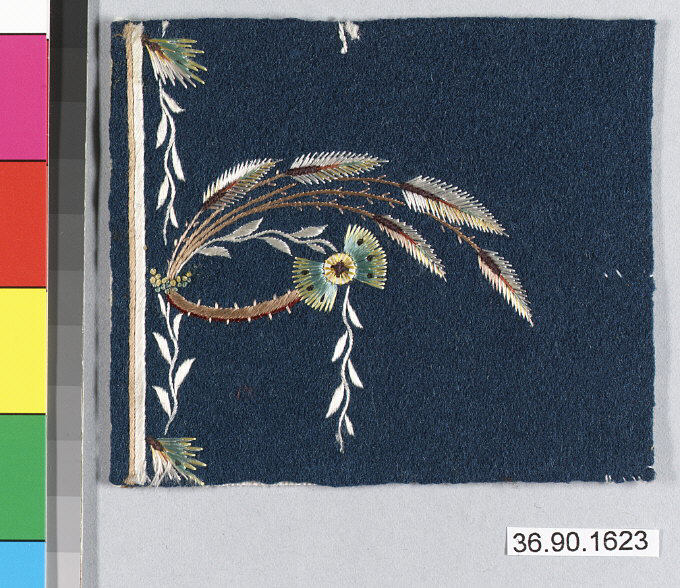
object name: sample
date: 1801-1833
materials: felt, silk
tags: plants